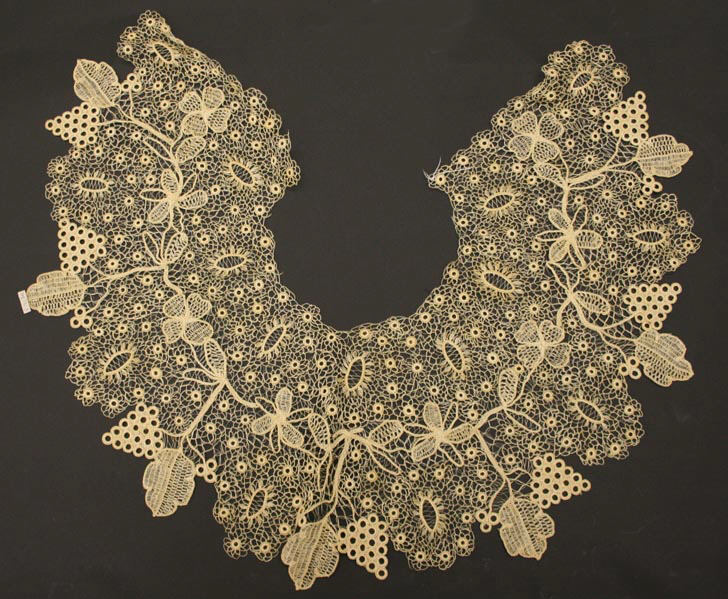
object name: collar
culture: greek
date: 1801-1900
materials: fiber